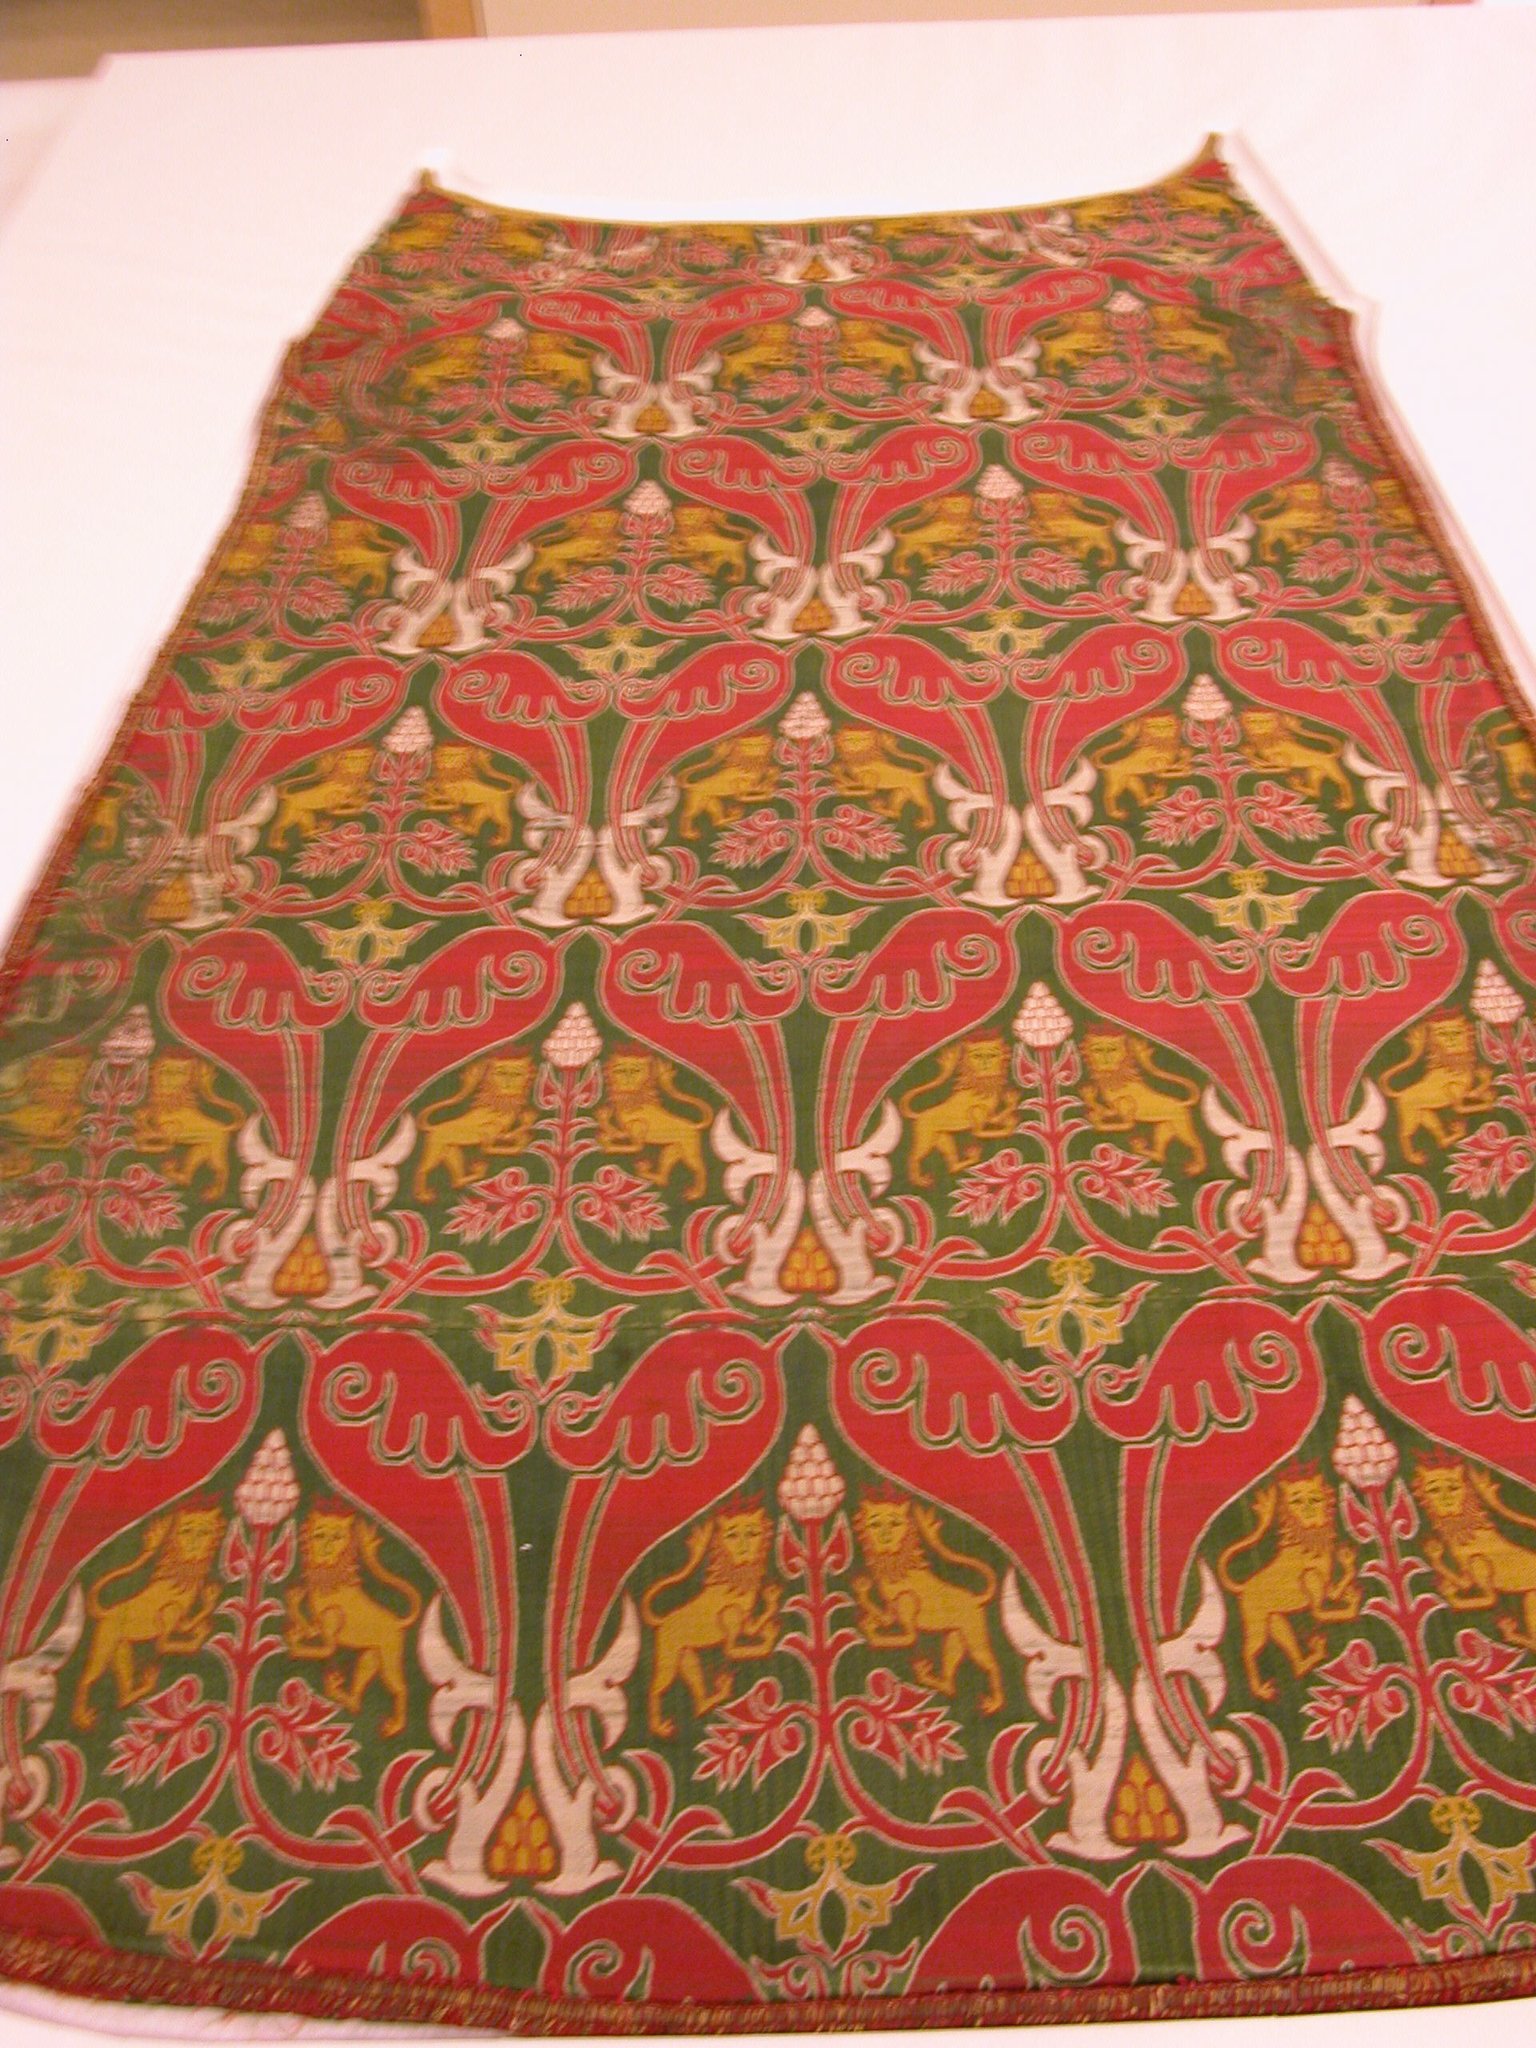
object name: textile fragment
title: Fragment of Chasuble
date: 1401-1500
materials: silk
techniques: lampas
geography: spain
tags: lions